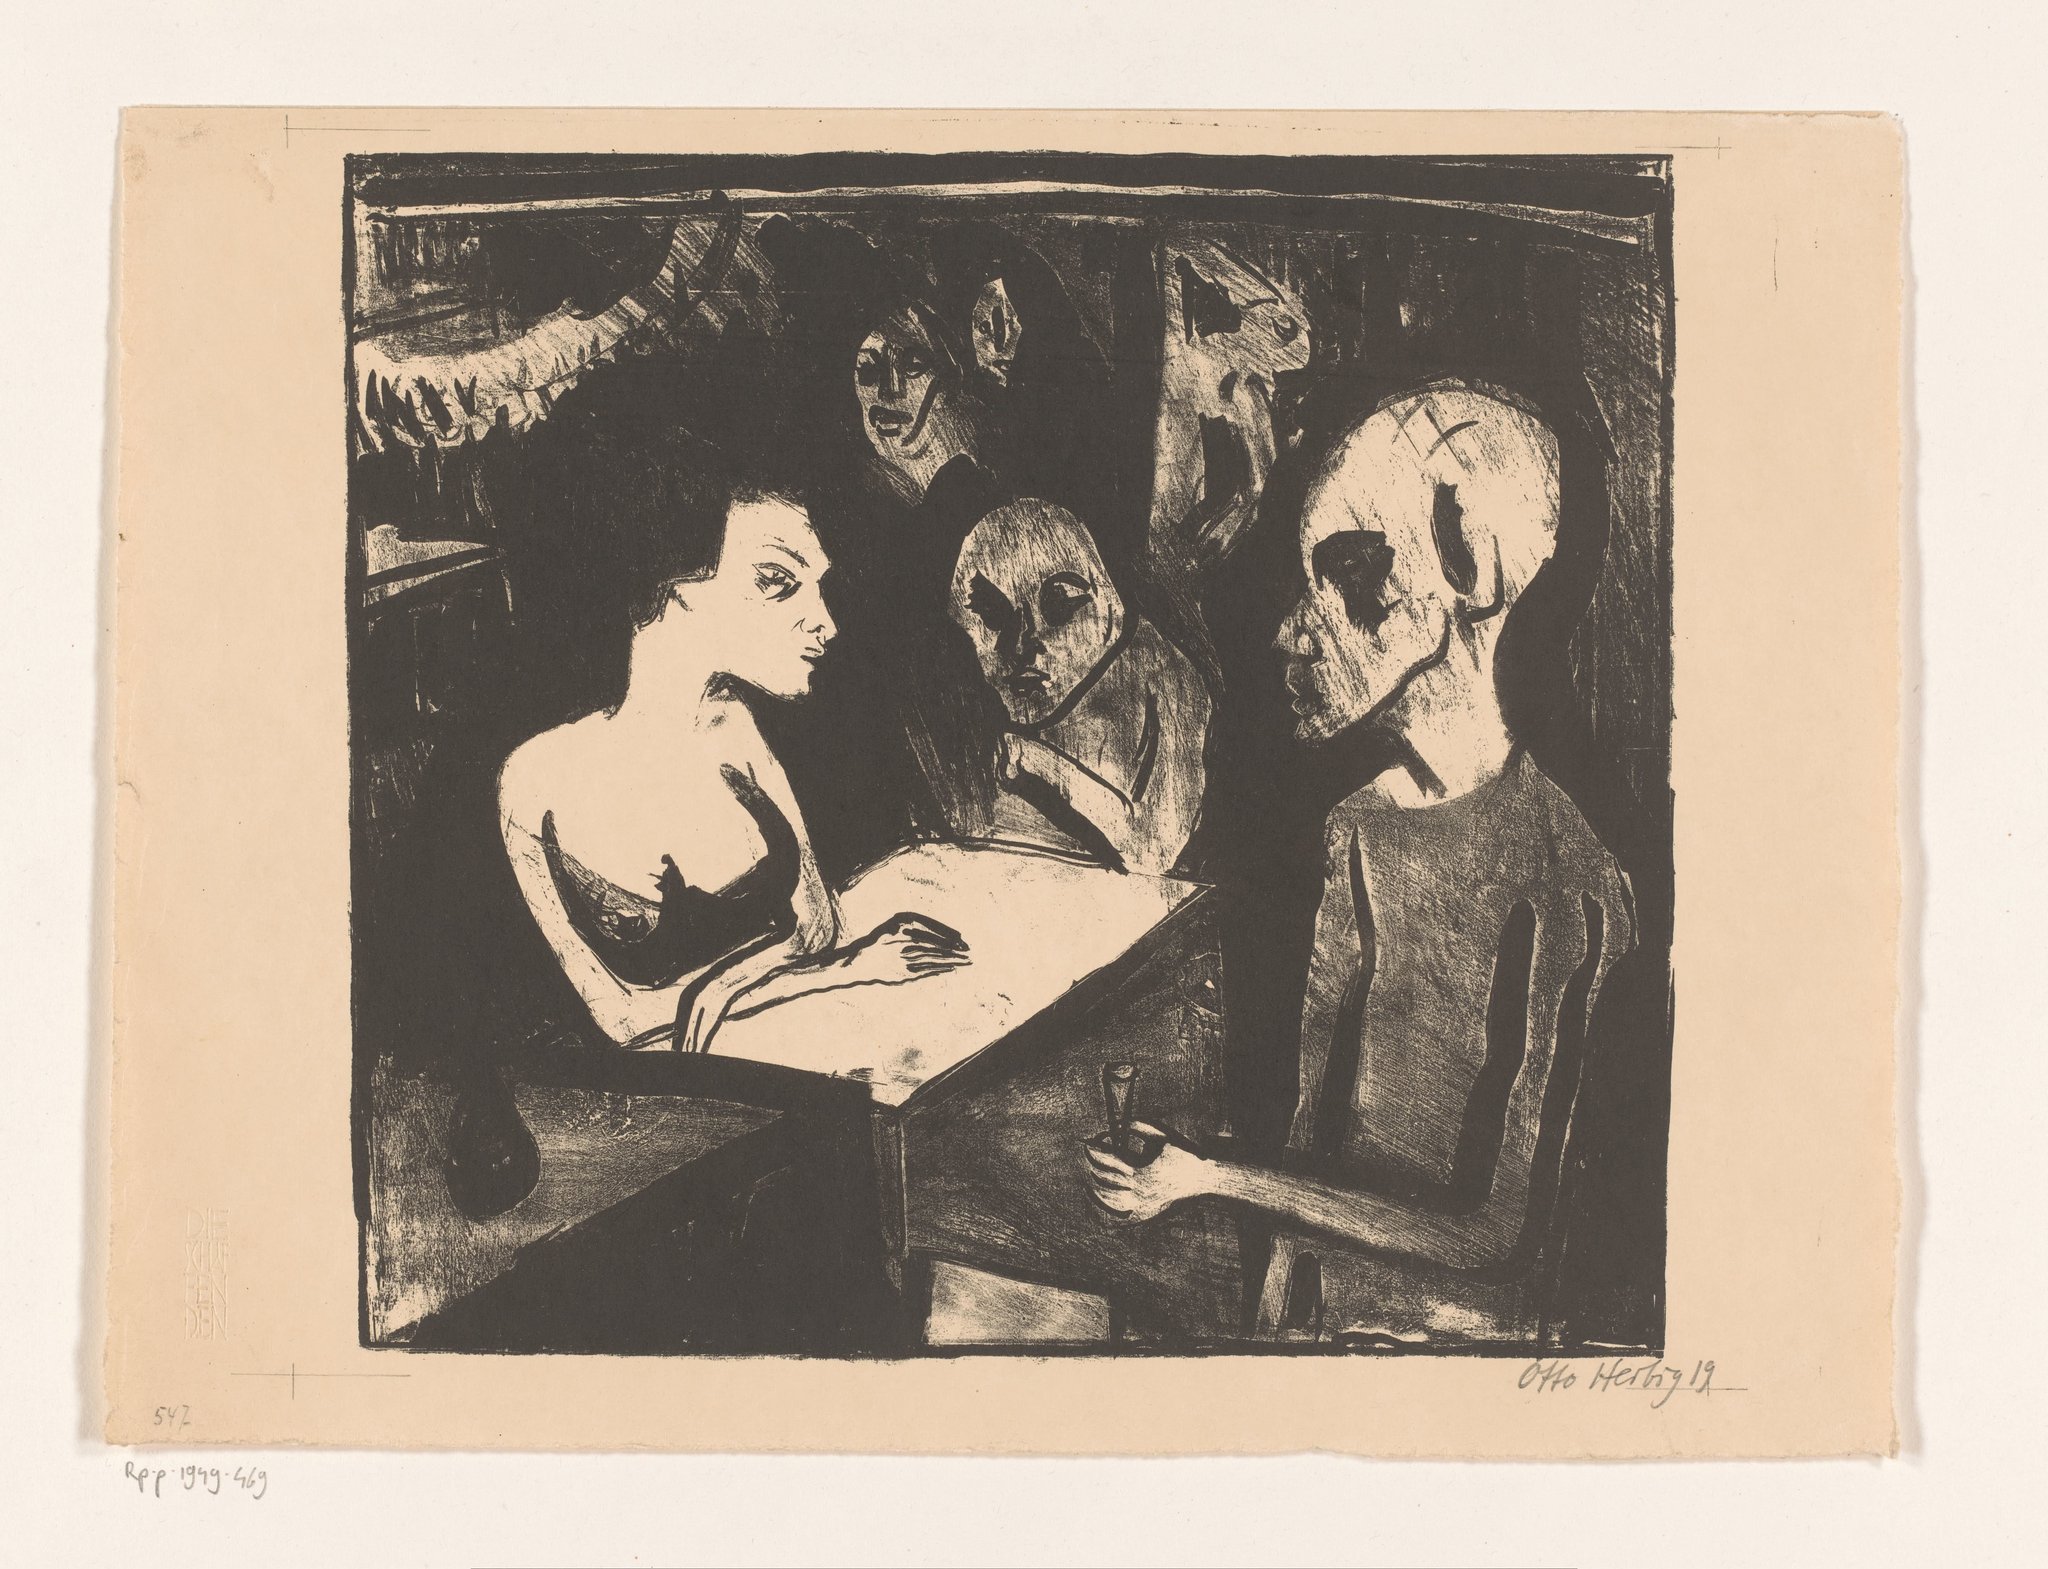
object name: print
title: Boslandschap met figuren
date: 1613-1695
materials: paper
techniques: etching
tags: landscapes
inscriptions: collector's mark: Lugt 2228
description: Prenten met het signatuur 'Perelle' kunnen zowel door vader Gabriel als door zonen Nicolas en Adam gemaakt zijn.